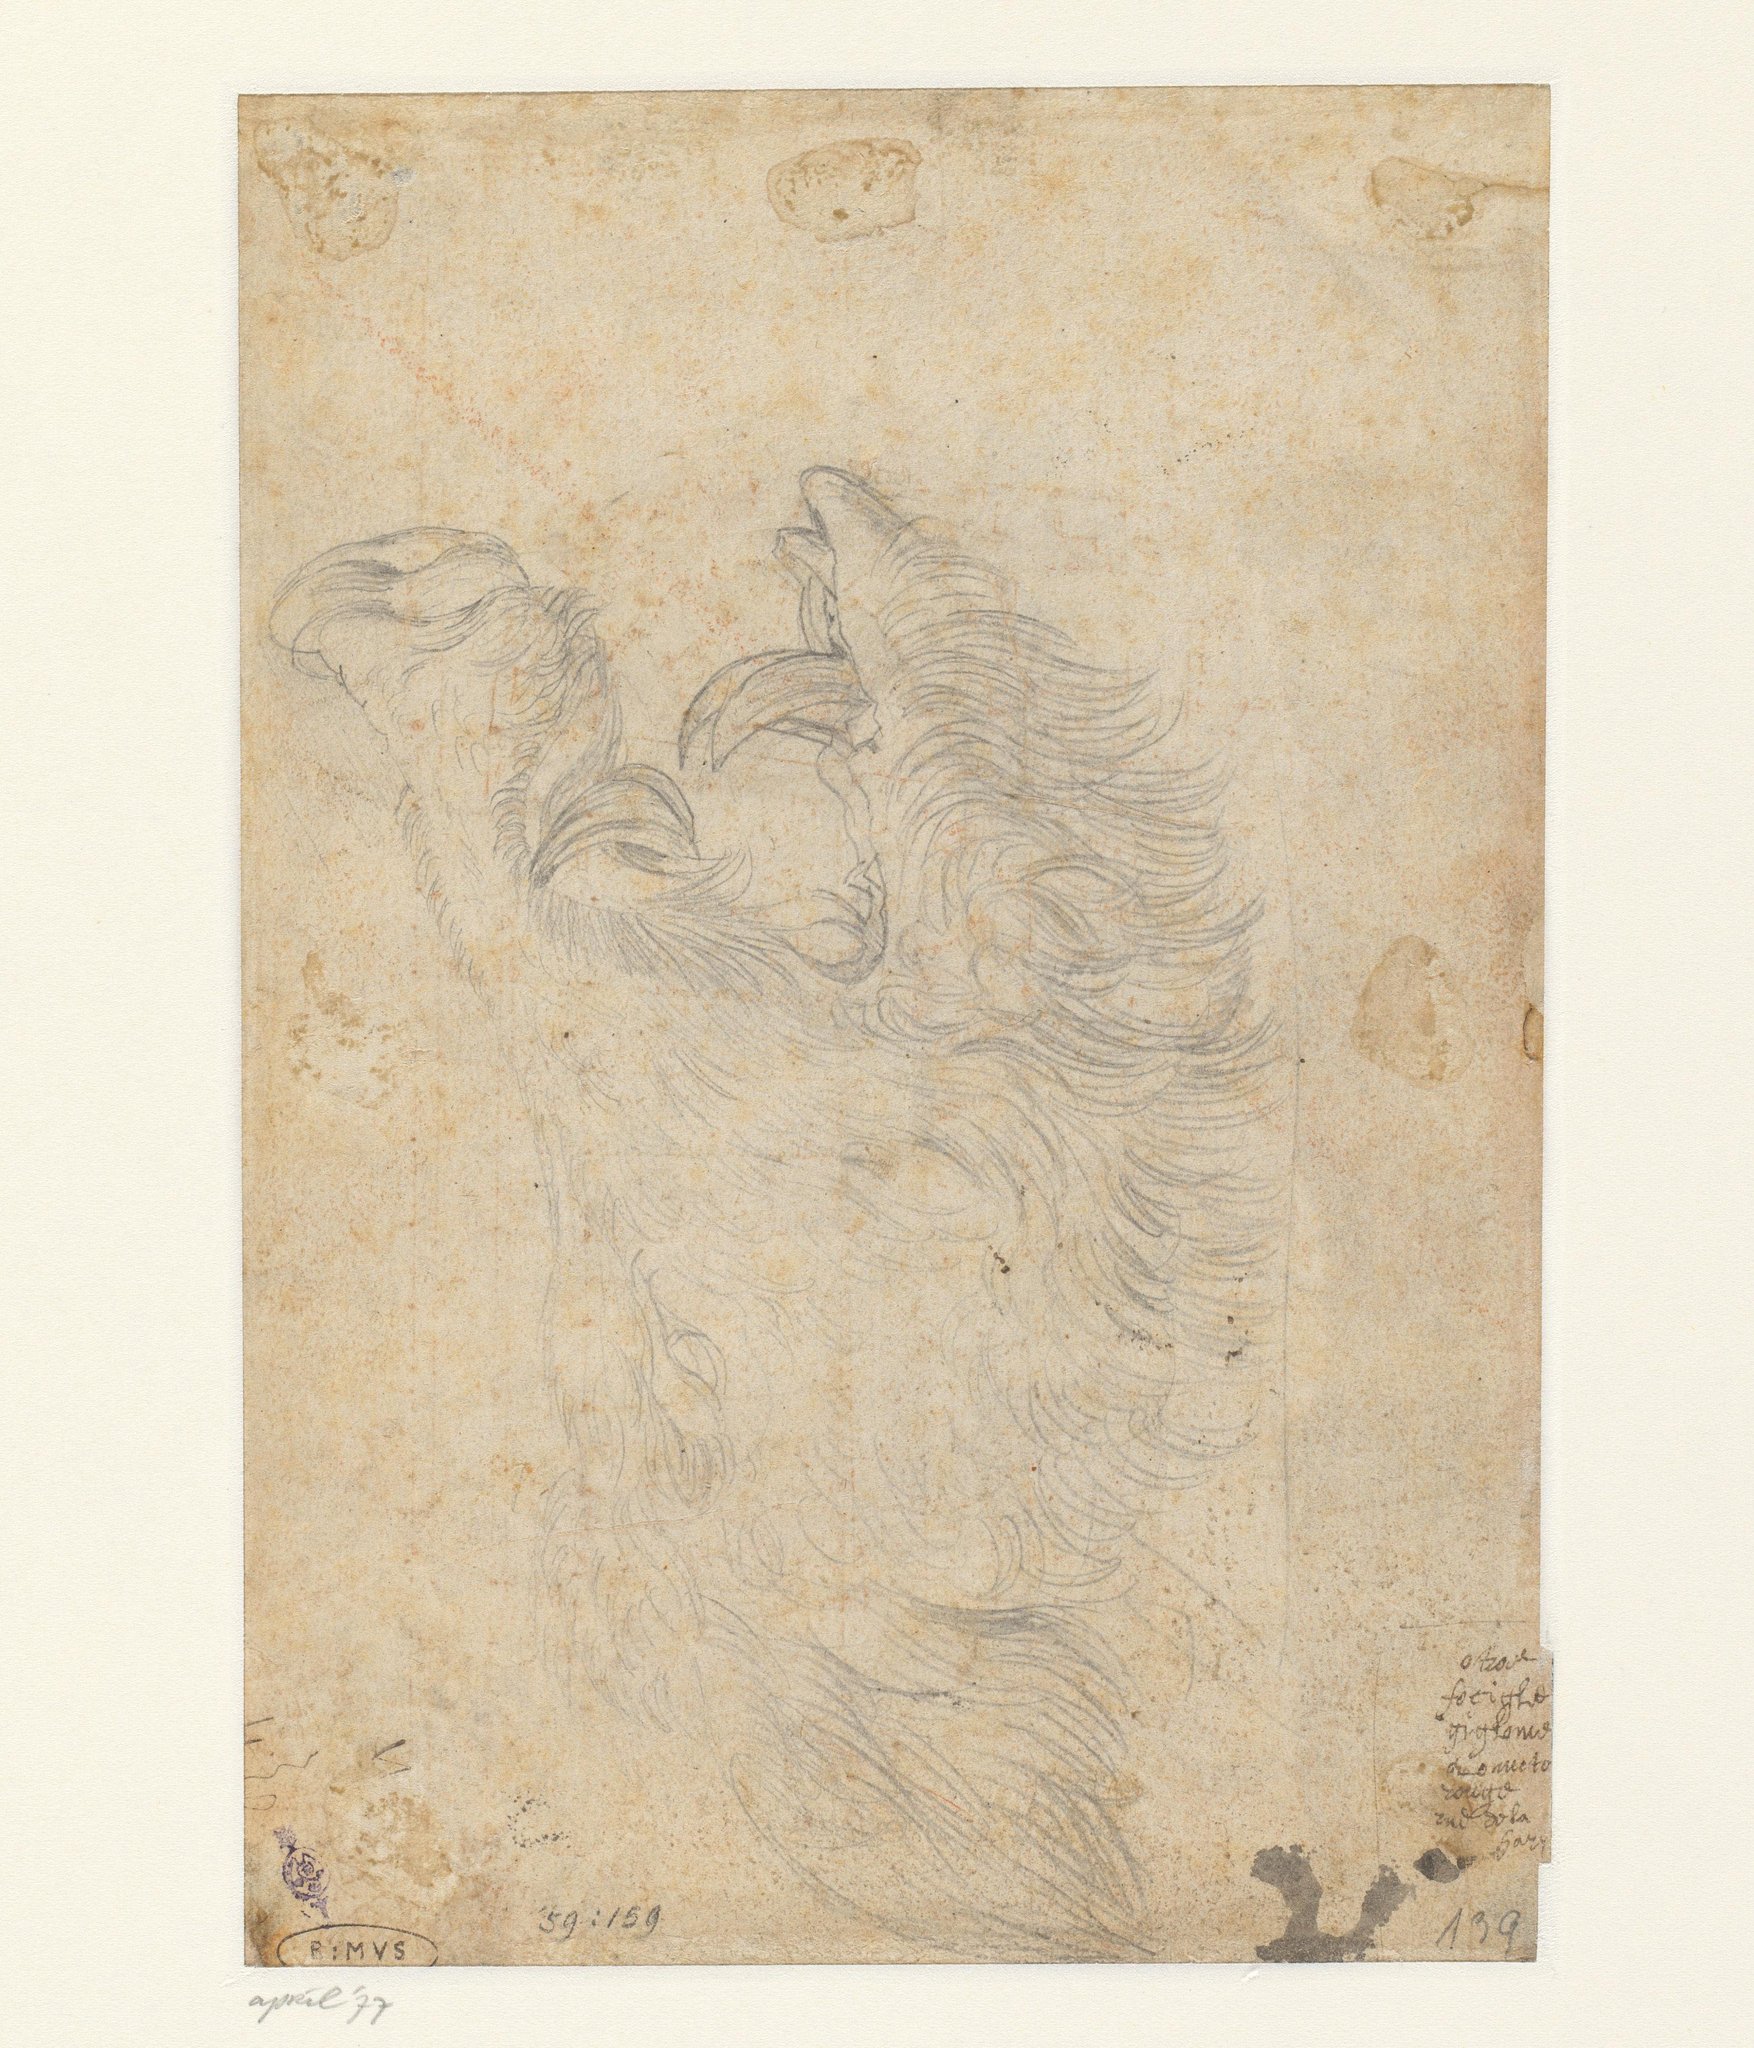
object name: drawing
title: Kop van een wild zwijn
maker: Anonymous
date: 1575-1625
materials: paper, pencil